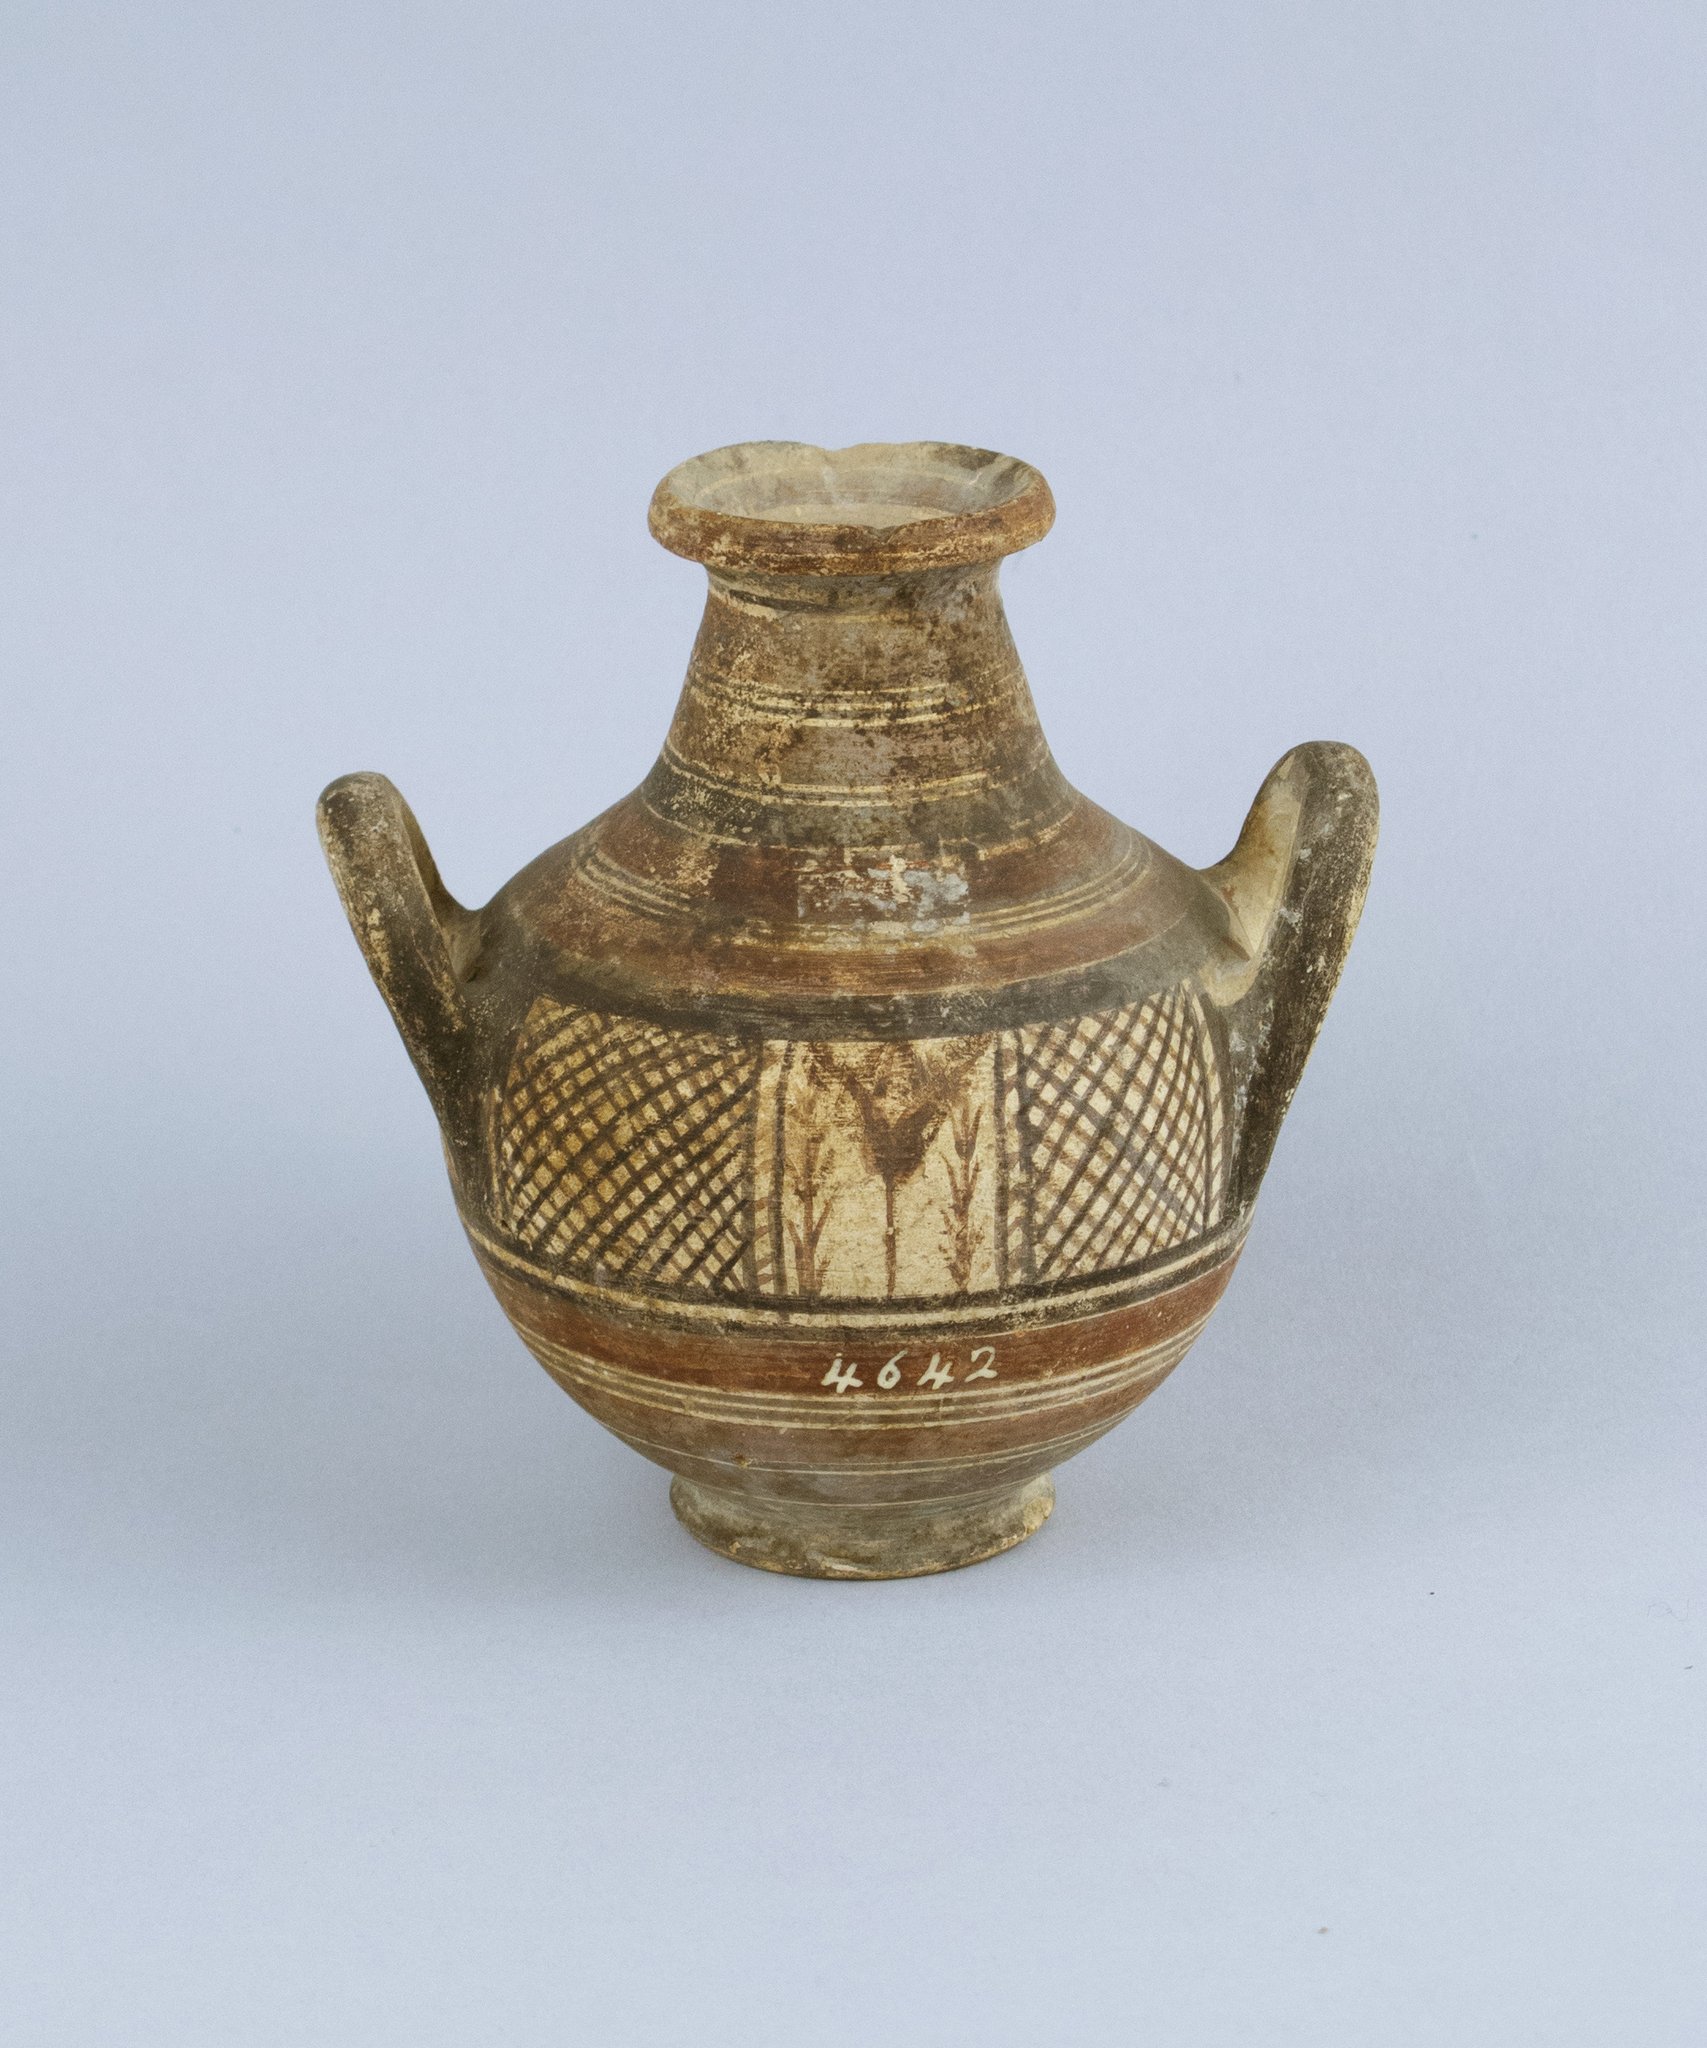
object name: amphora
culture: cypriot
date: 600-480 BCE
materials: terracotta